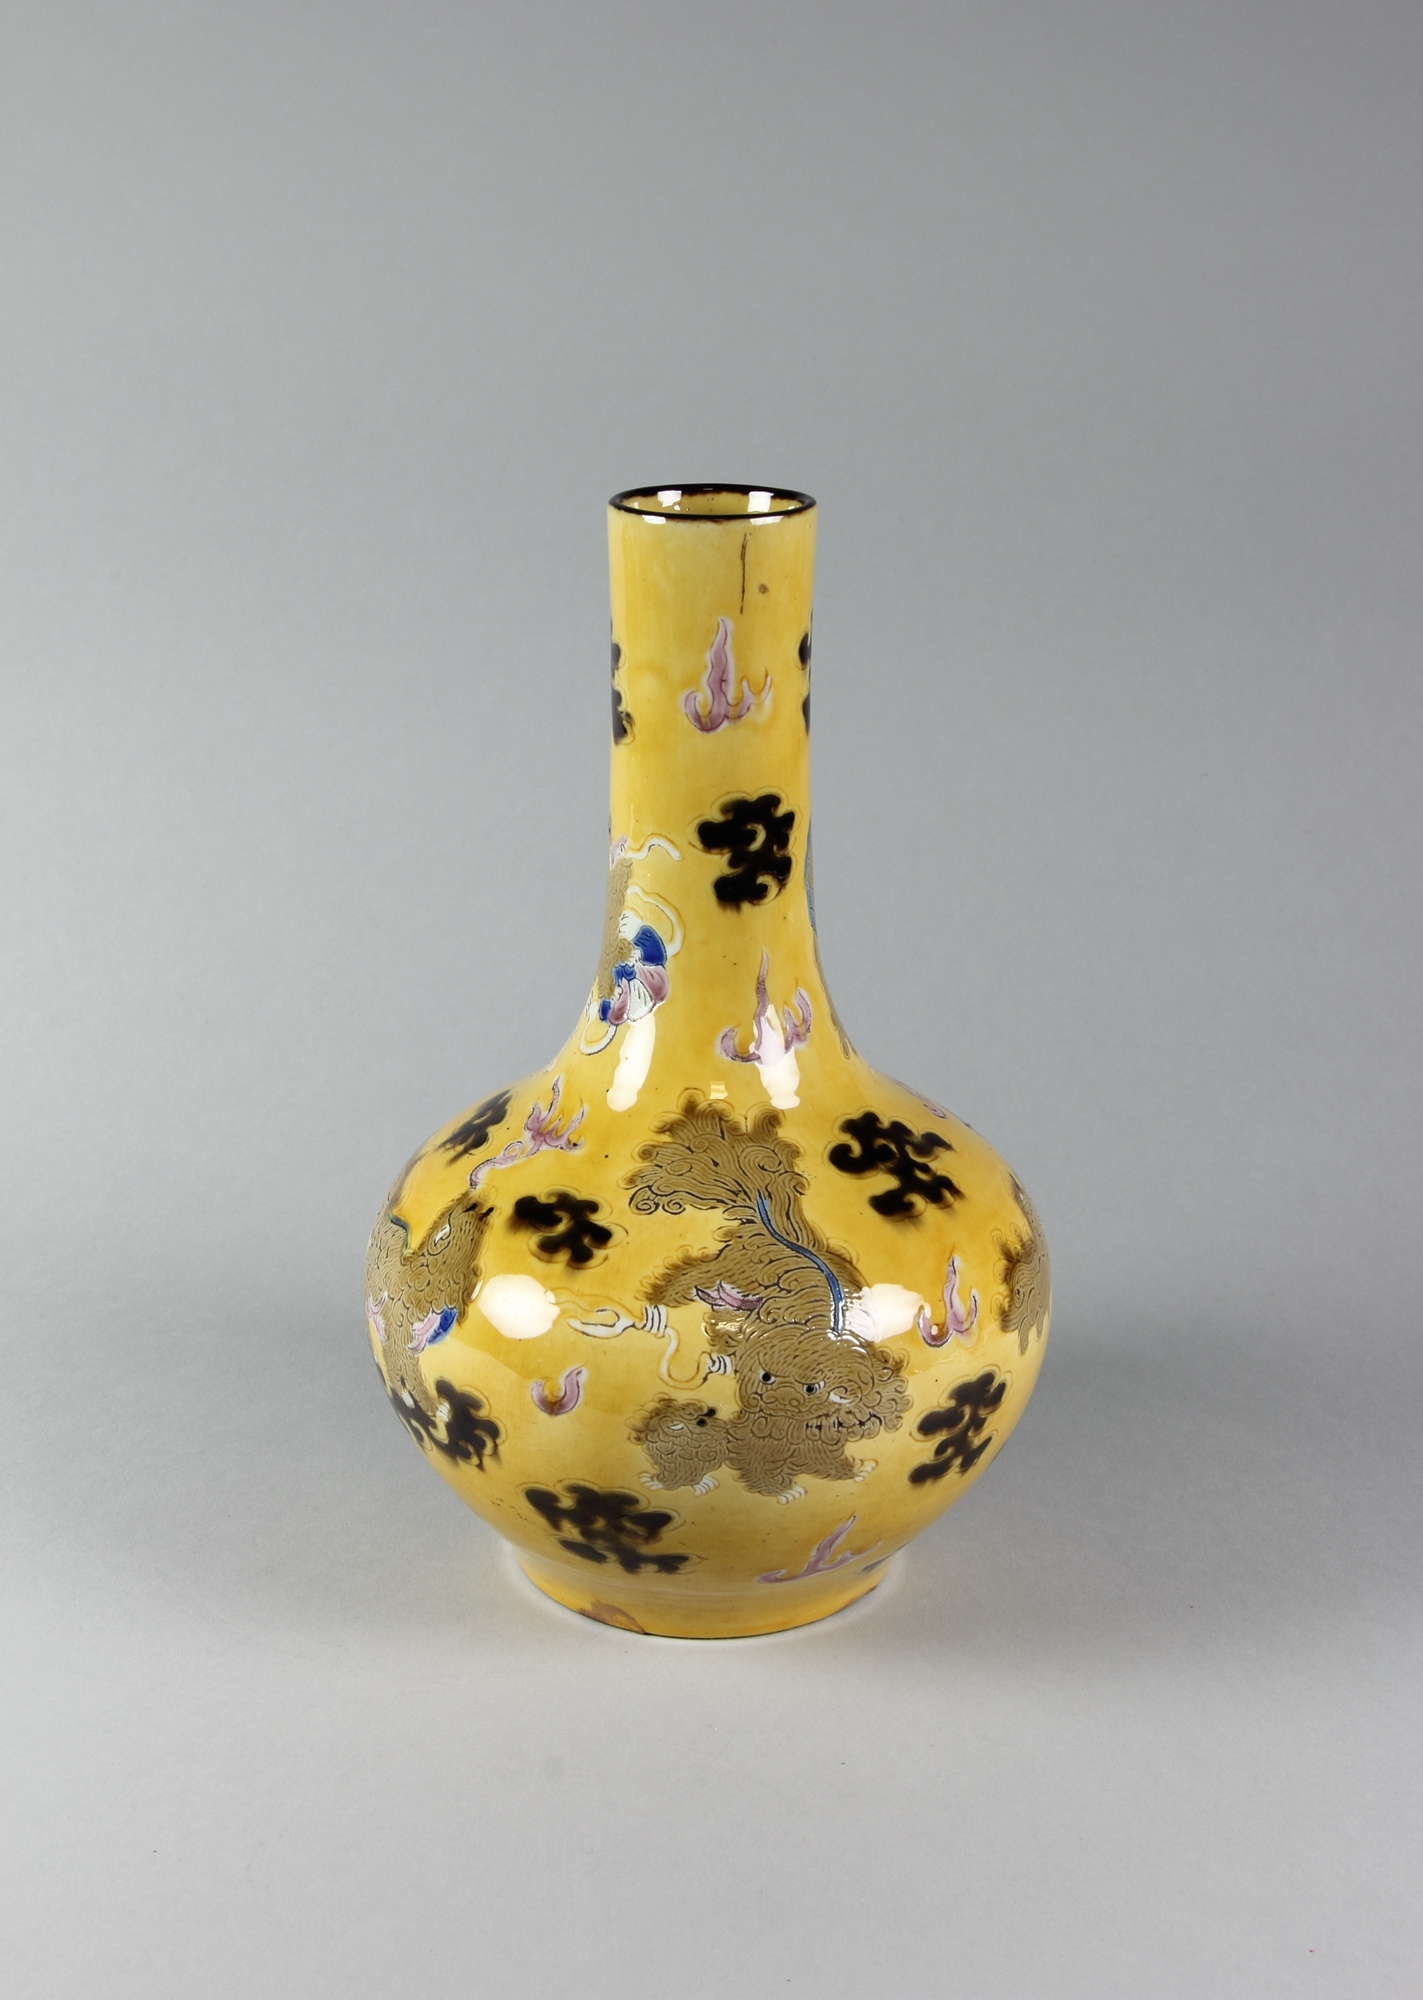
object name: vase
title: Vase with lions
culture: chinese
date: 1801-1850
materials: glaze, porcelain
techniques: incising, polychrome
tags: dragons